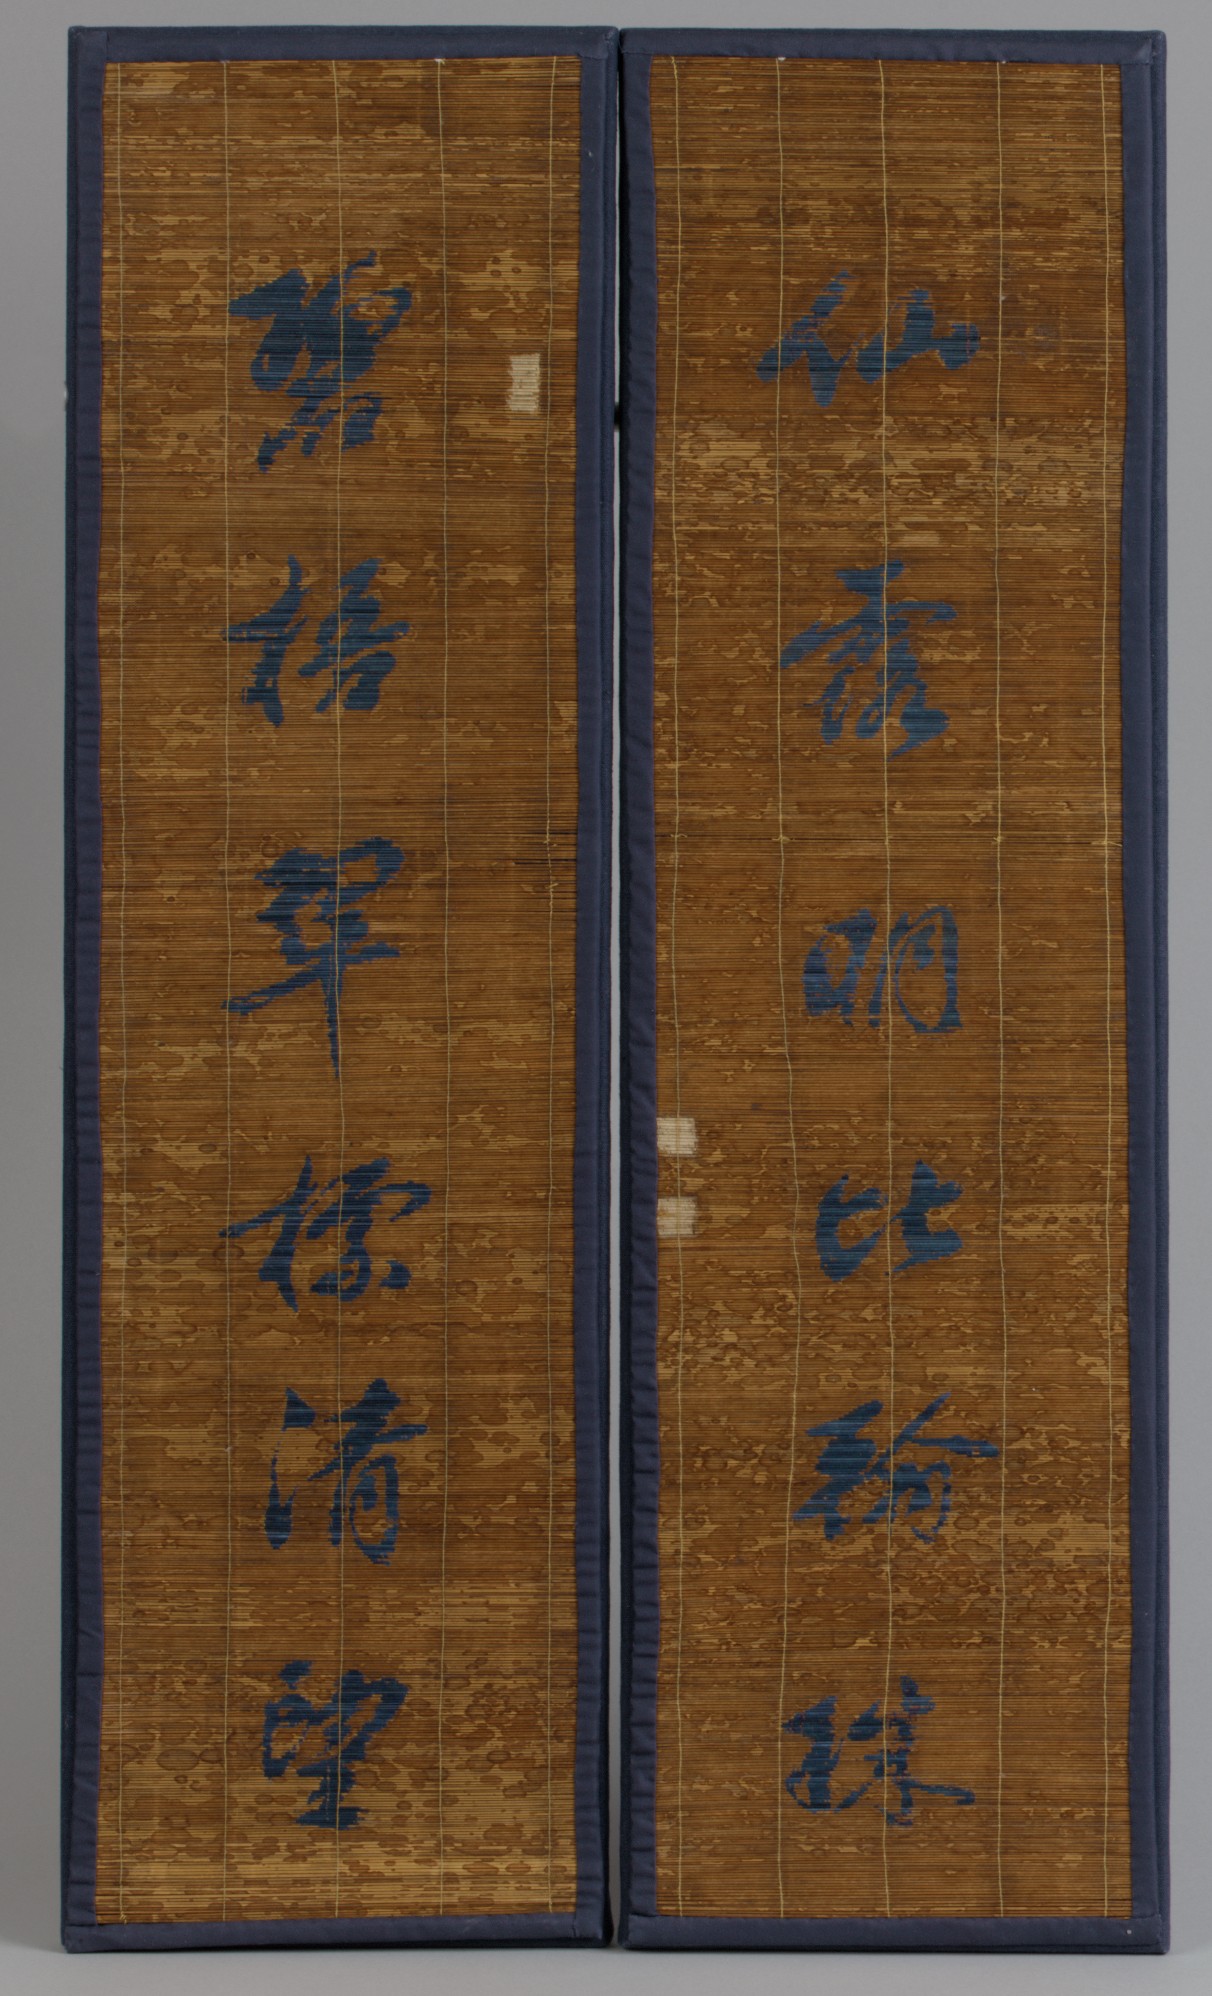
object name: blind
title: Calligraphy Couplet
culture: chinese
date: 1701-1800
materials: bamboo, silk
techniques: embroidery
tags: poetry,calligraphy